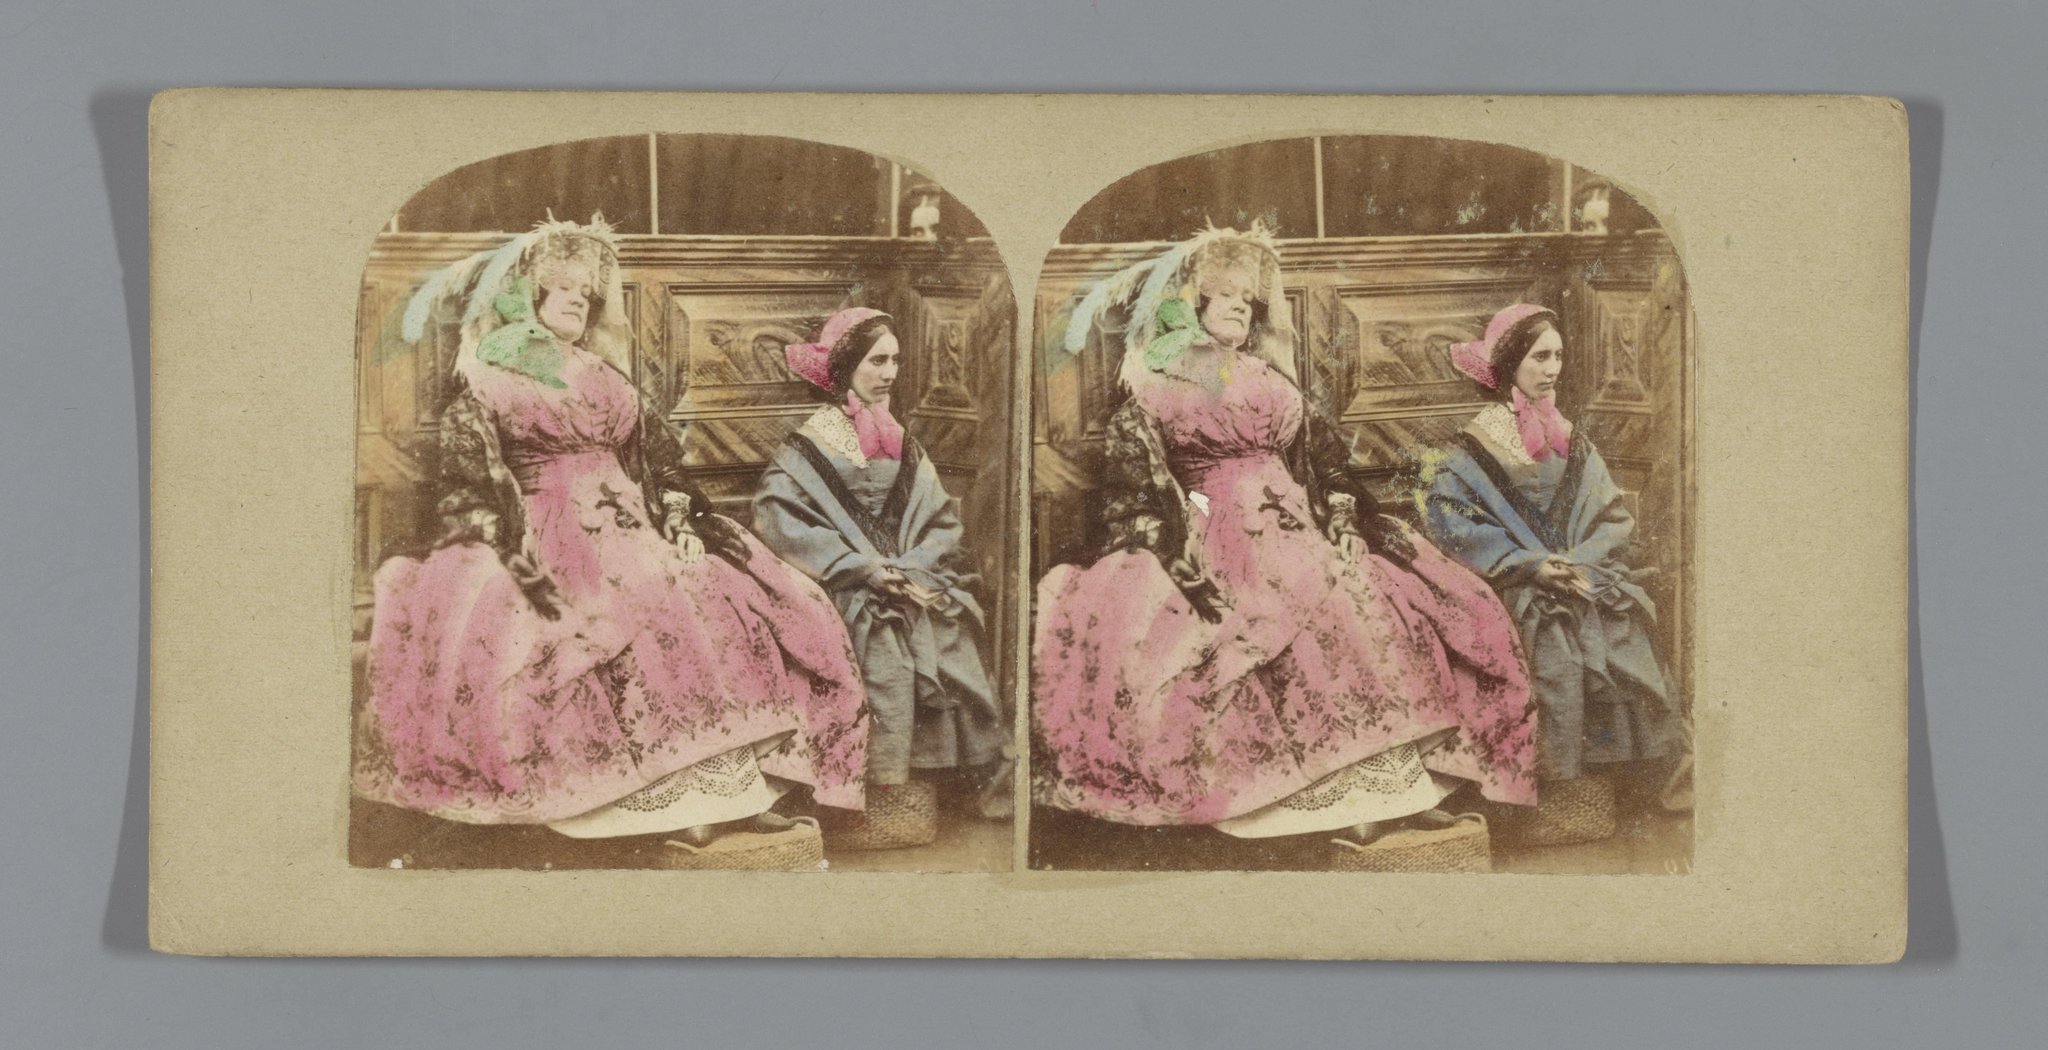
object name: stereograph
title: Twee vrouwen worden begluurd door een derde vrouw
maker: Anonymous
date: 1852-1863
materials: cardboard, paper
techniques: albumen print, hand coloring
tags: sleeping; unconsciousness